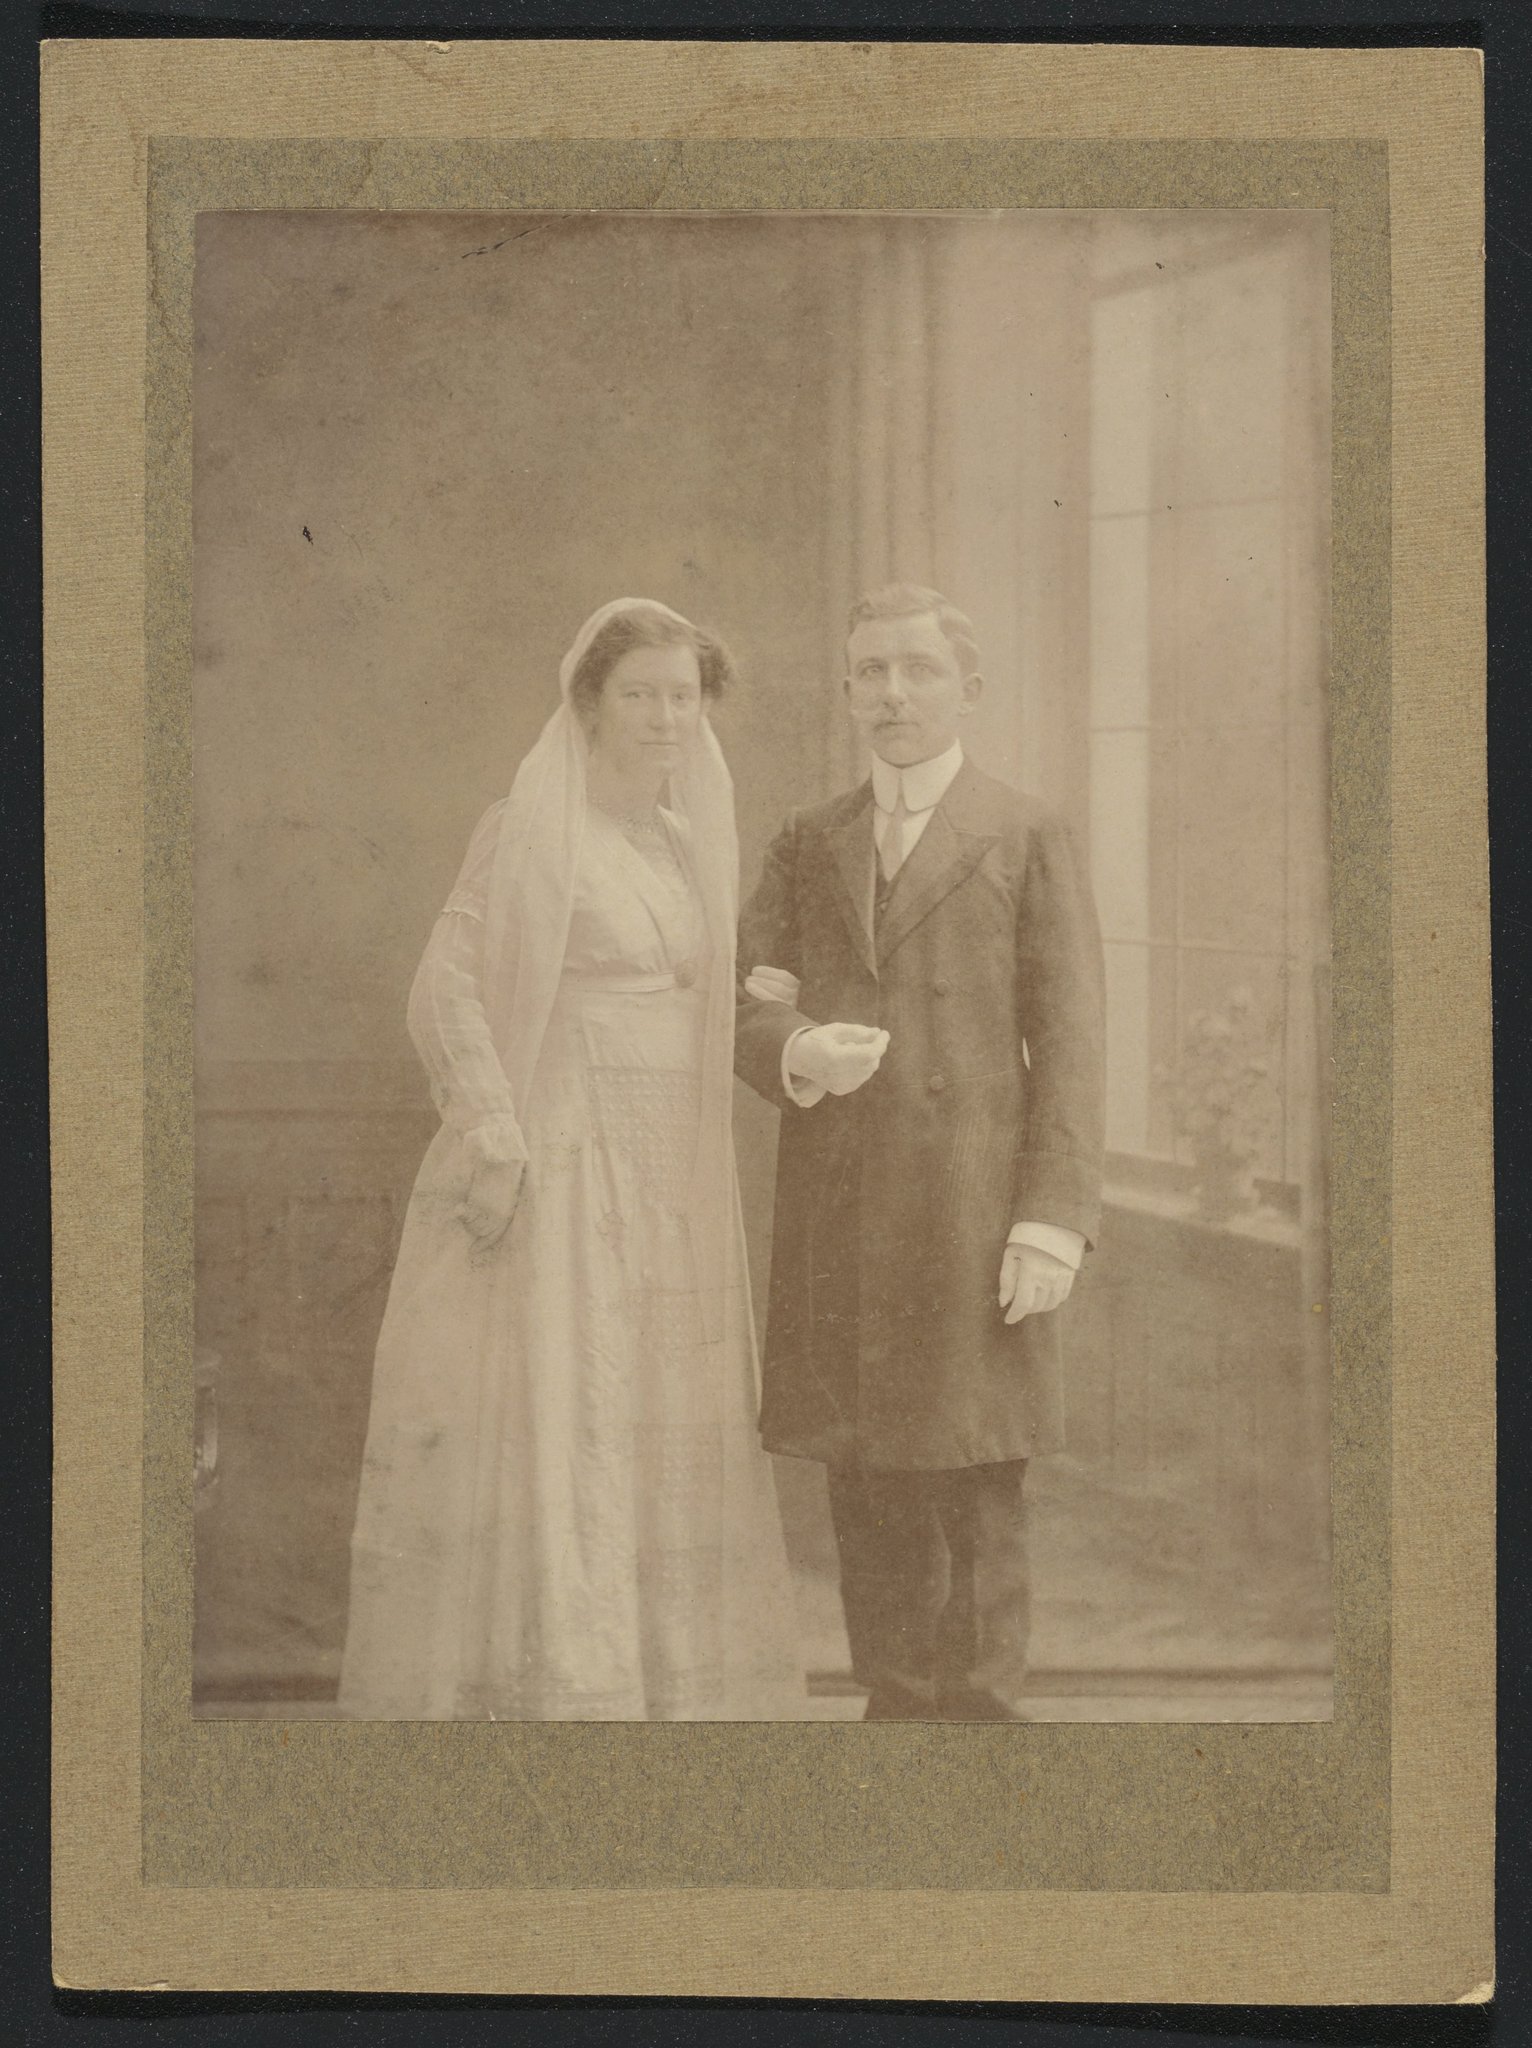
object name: photograph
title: Huwelijksfoto van Johannes Willem de Roever en Paulina Brigitte Wolbers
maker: b. knopper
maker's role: fotograaf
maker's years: 1870-1932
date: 1911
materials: cardboard, paper, photographic support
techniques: daylight paper print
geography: overveen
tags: den helder, haarlem, bride and groom in wedding-dress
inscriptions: inscription: ‘Trouwfoto 1911 JW de Roever en PB Wolbers tussen zijden japons en Tenerife-handwerk’, signature: ‘B. Knopper, Nassaukade 155, Amst.’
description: Foto van het bruidspaar Johannes Willem de Roever en Paulina Brigitte Wolbers. Het paar staat voor een achterdoek, voorstellende een hoek van een kamer met betimmering en een raam met een plant midden op de vensterbank, gefotografeerd. De bruid houdt met haar linkerarm de rechterarm van de bruidegom. Zij is gekleed in een lichte bruidsjapon met hoge taille en lange mouwen. Op het hoofd een sluier. De bruidegom draagt een double-breasted jas met brede revers, een vest en broek. Verder een wit overhemd met stijve boord en een geknoopte das. Kort haar met een scheiding links en een puntige snor.